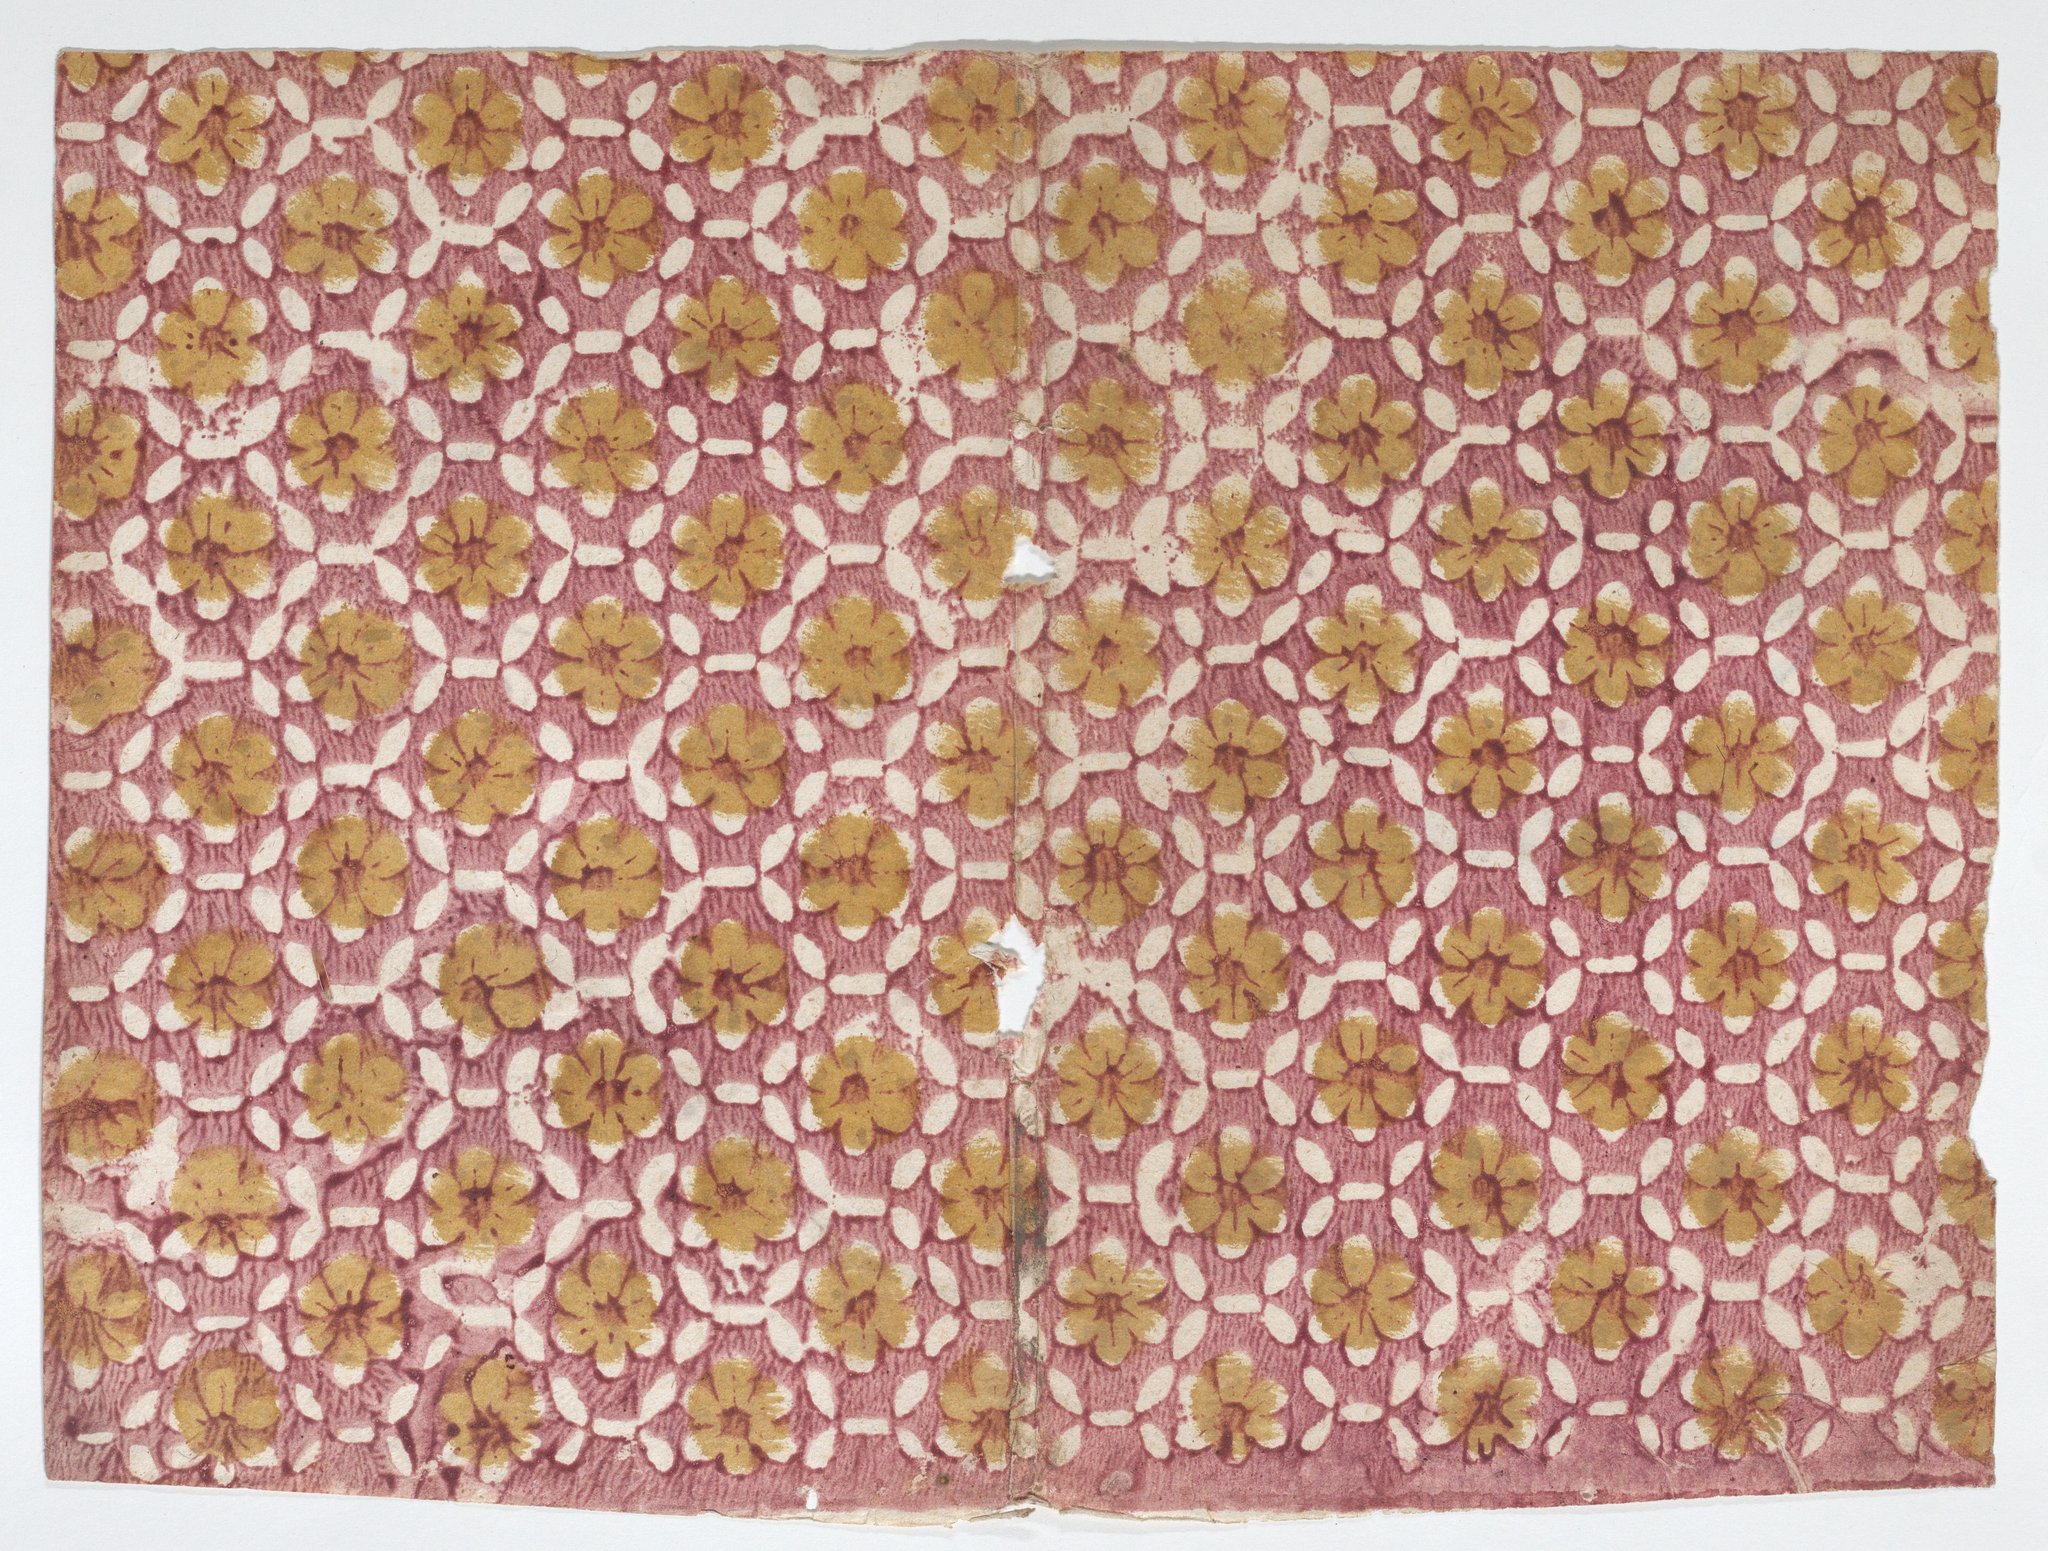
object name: print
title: Book cover with overall red floral pattern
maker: Anonymous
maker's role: artist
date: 1701-1800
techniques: relief print